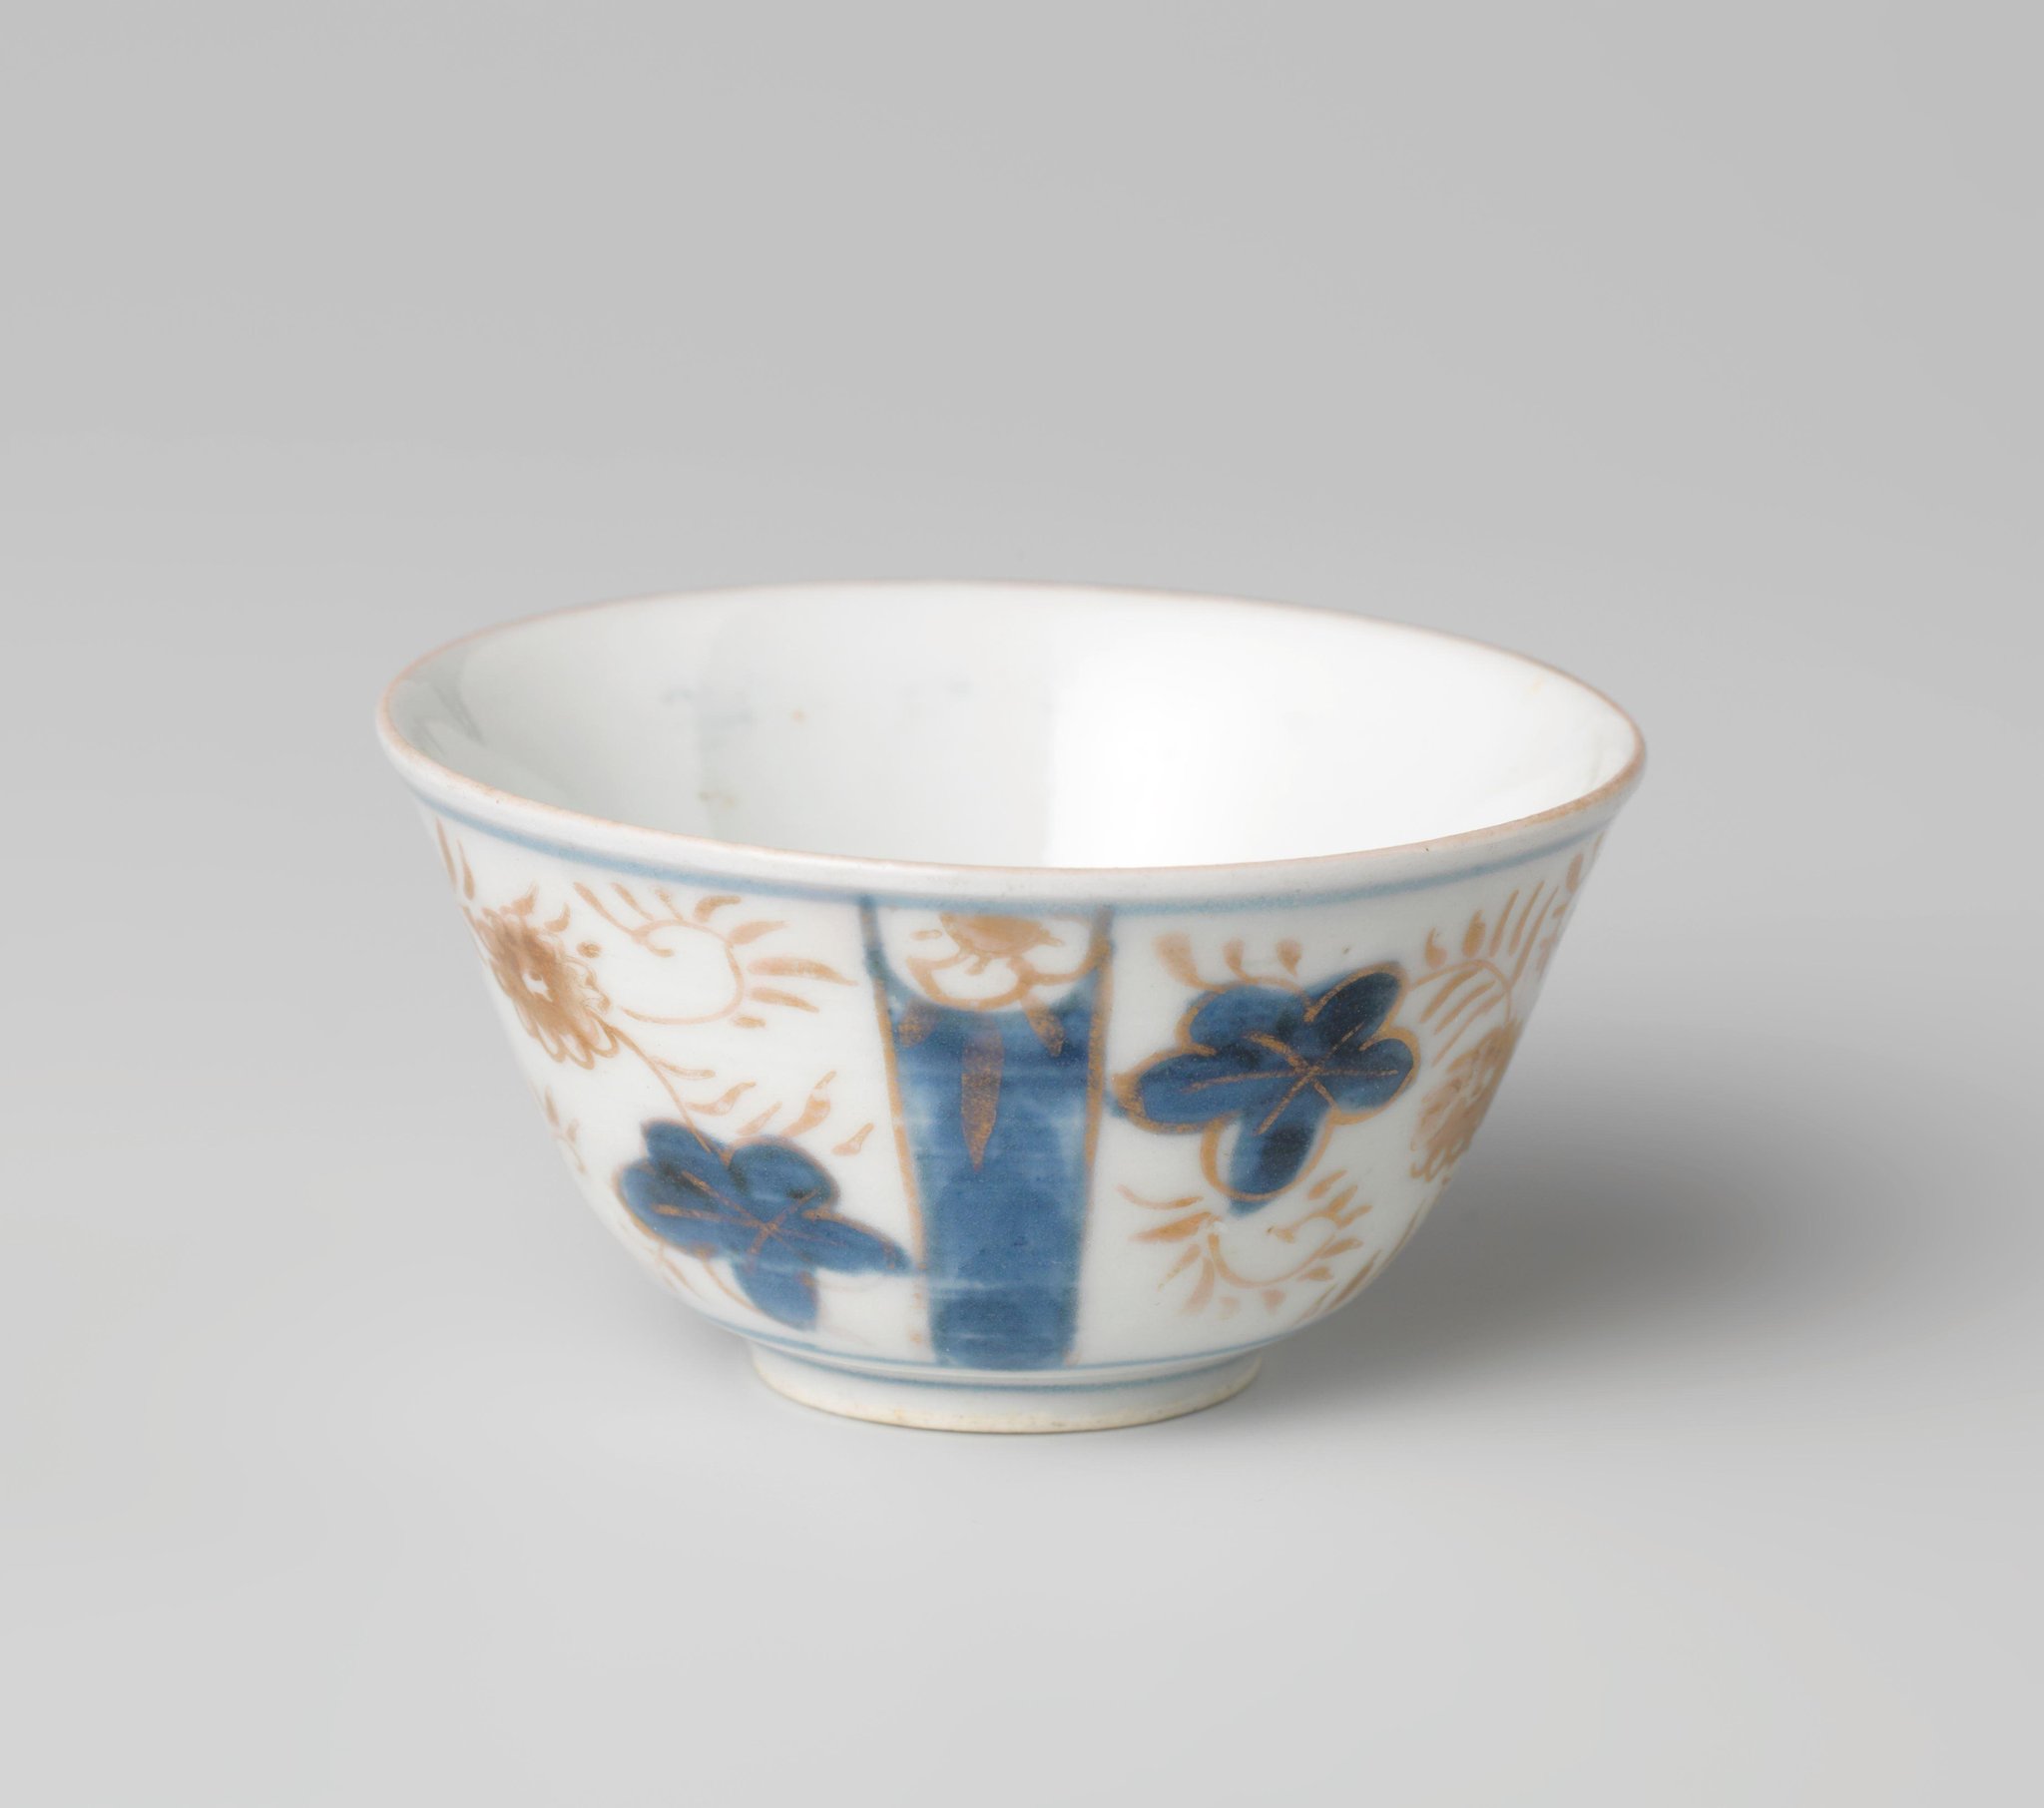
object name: cup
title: Bell-shaped cup with a flower basket and floral scrolls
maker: Anonymous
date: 1775-1799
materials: cobalt, glaze, gold, paint, porcelain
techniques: firing, gilding, turning, vitrification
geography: japan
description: Klokvormige kop van porselein, beschilderd in onderglazuur blauw en op het glazuur goud. Op de bodem in een medaillon een bloempot. De wand is verdeeld in drie waaiervormige vakken gescheiden door een brede streep met een bloem. In de vakken bloemranken. Imari.